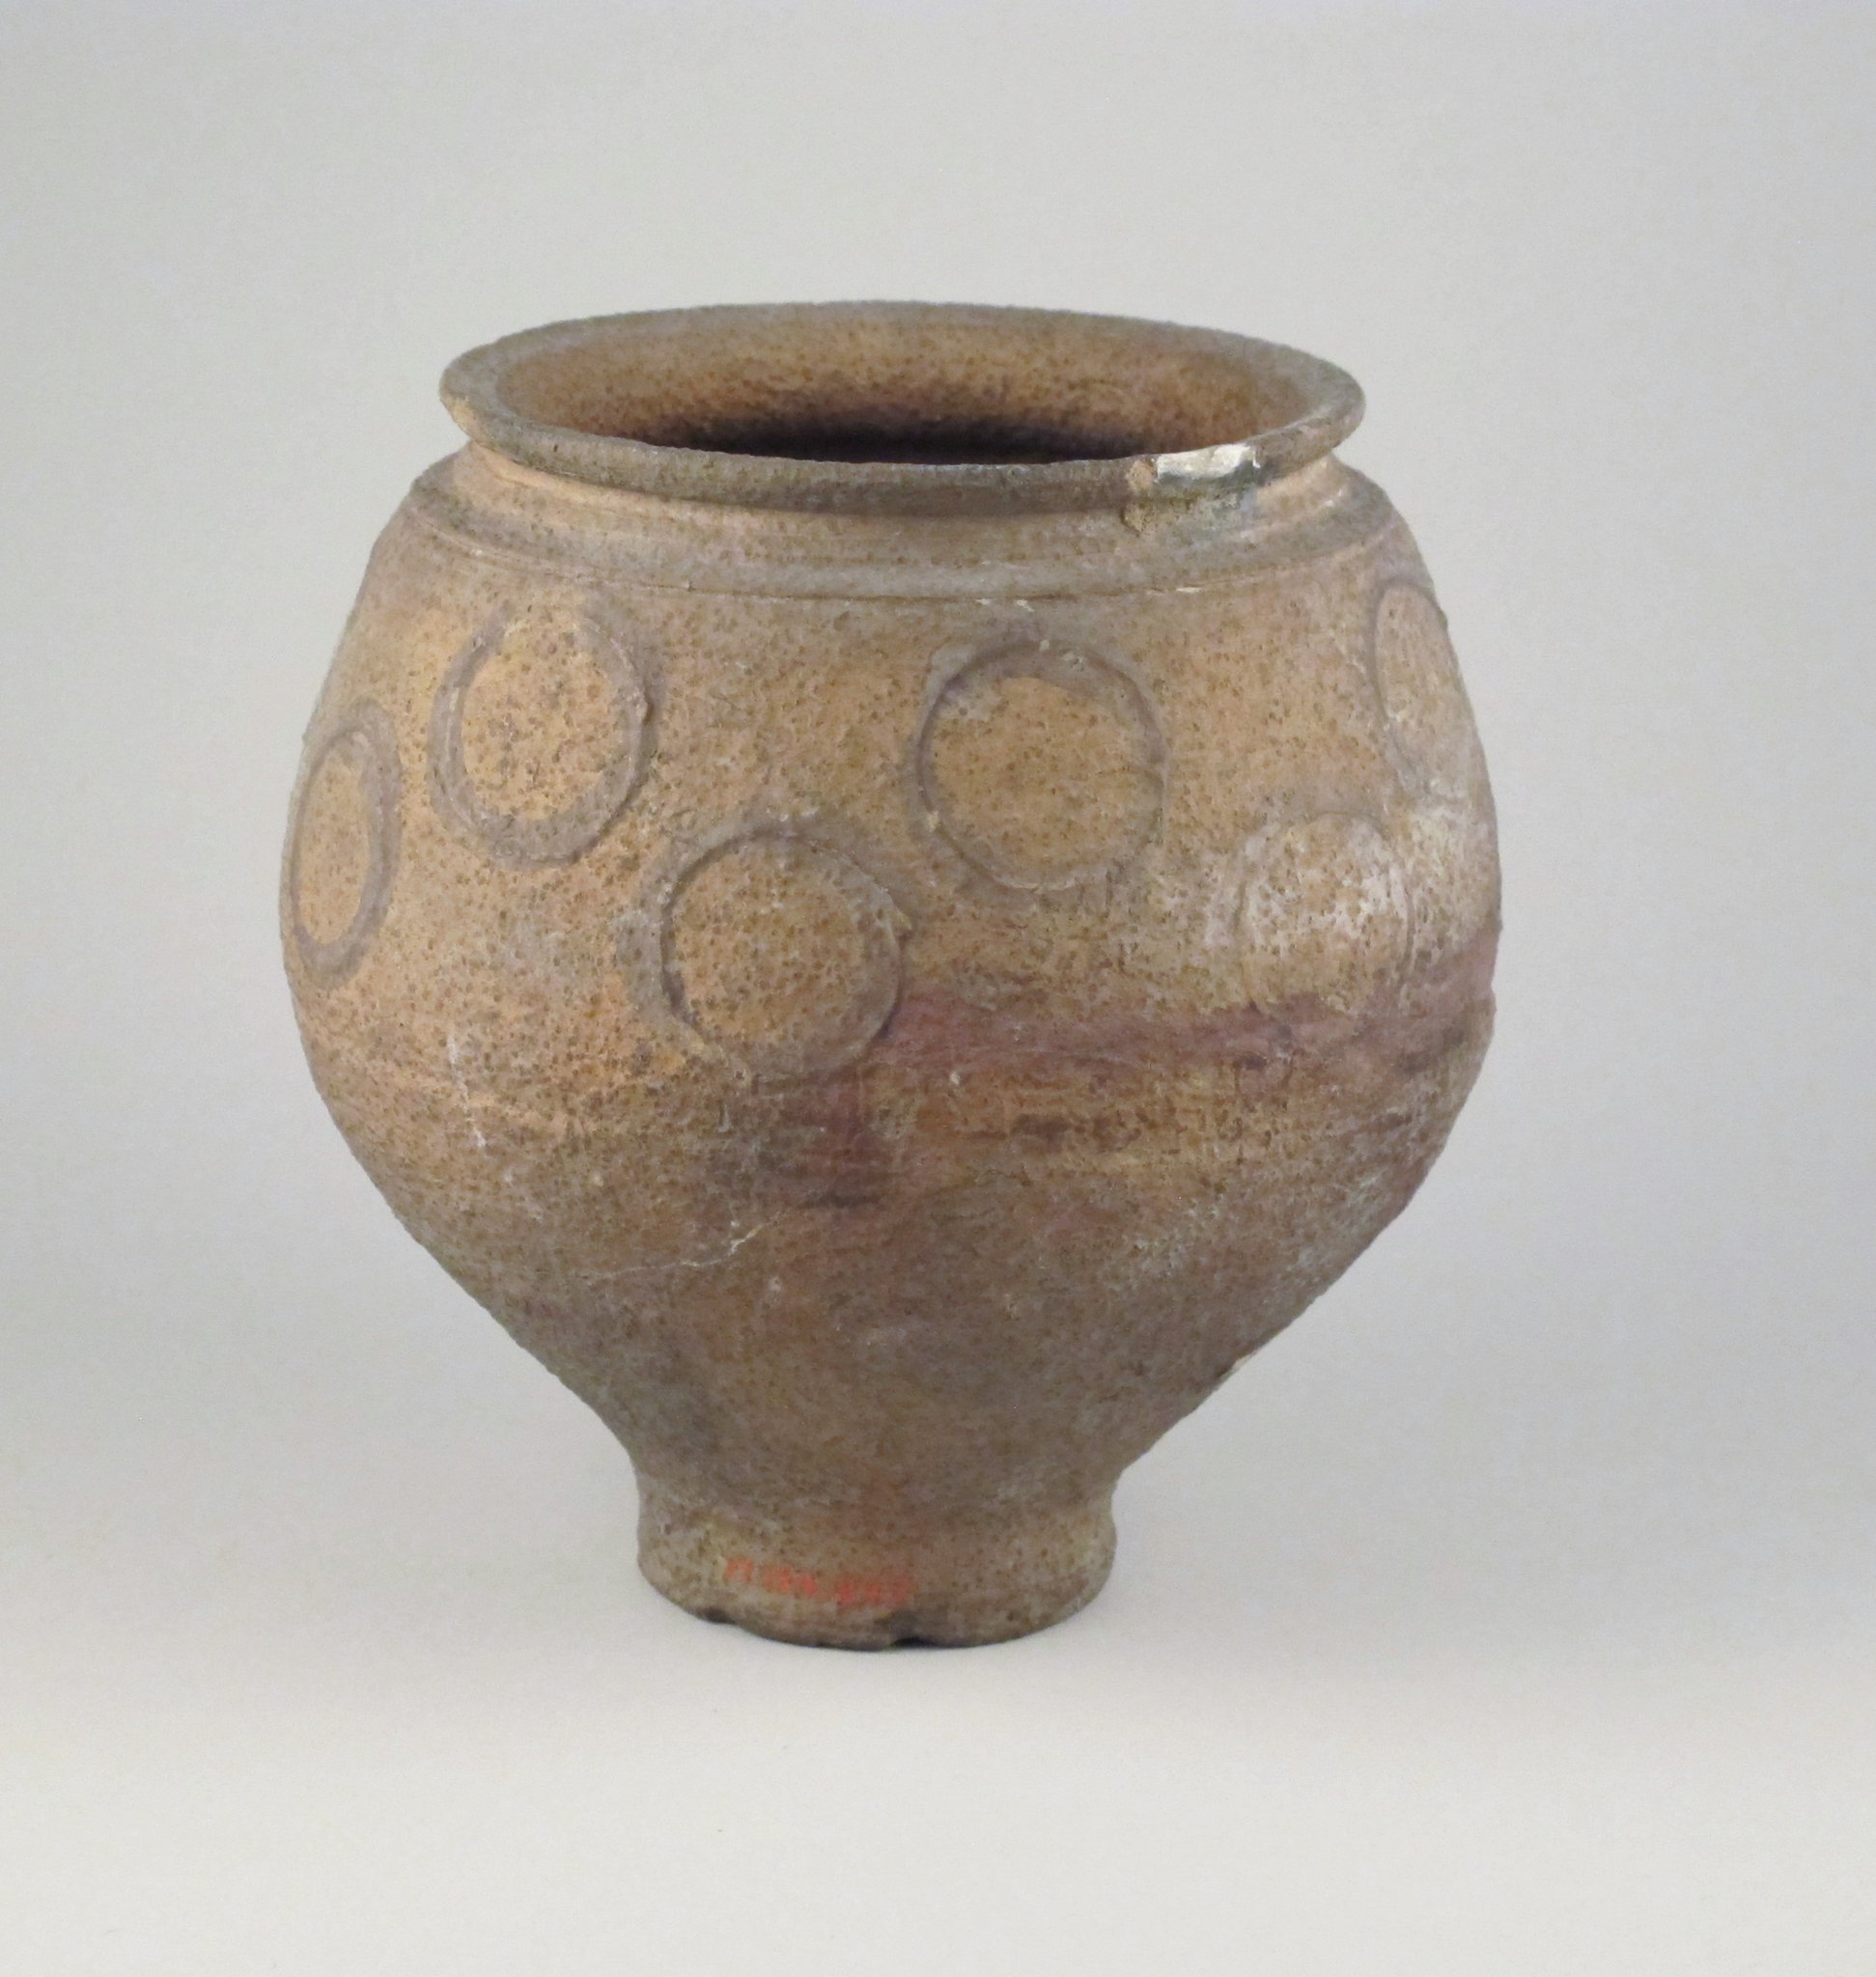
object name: vase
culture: roman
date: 1-100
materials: terracotta